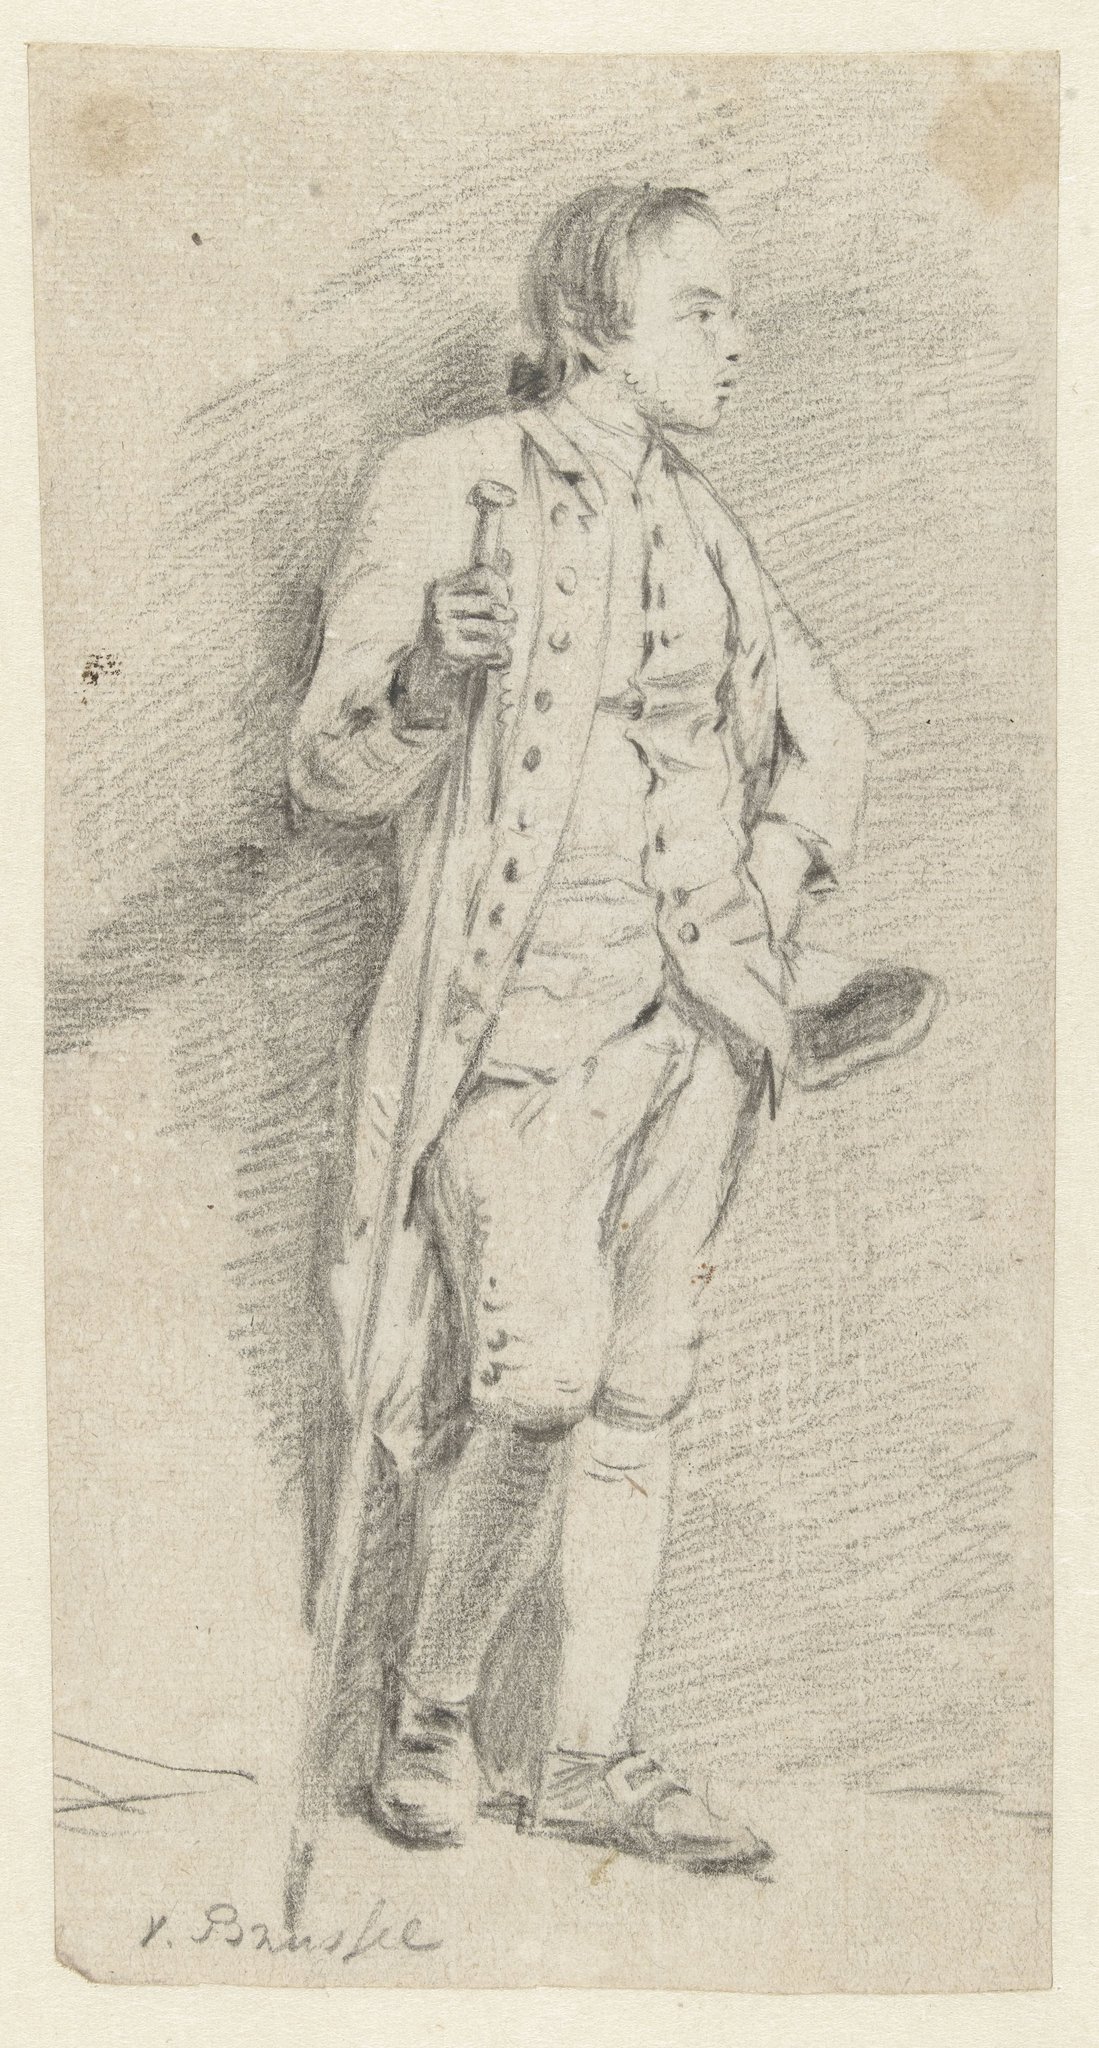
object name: drawing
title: Staande jongen met stok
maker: hermanus van brussel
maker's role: draughtsman, print maker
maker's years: 1763-1815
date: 1773-1815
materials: chalk, paper